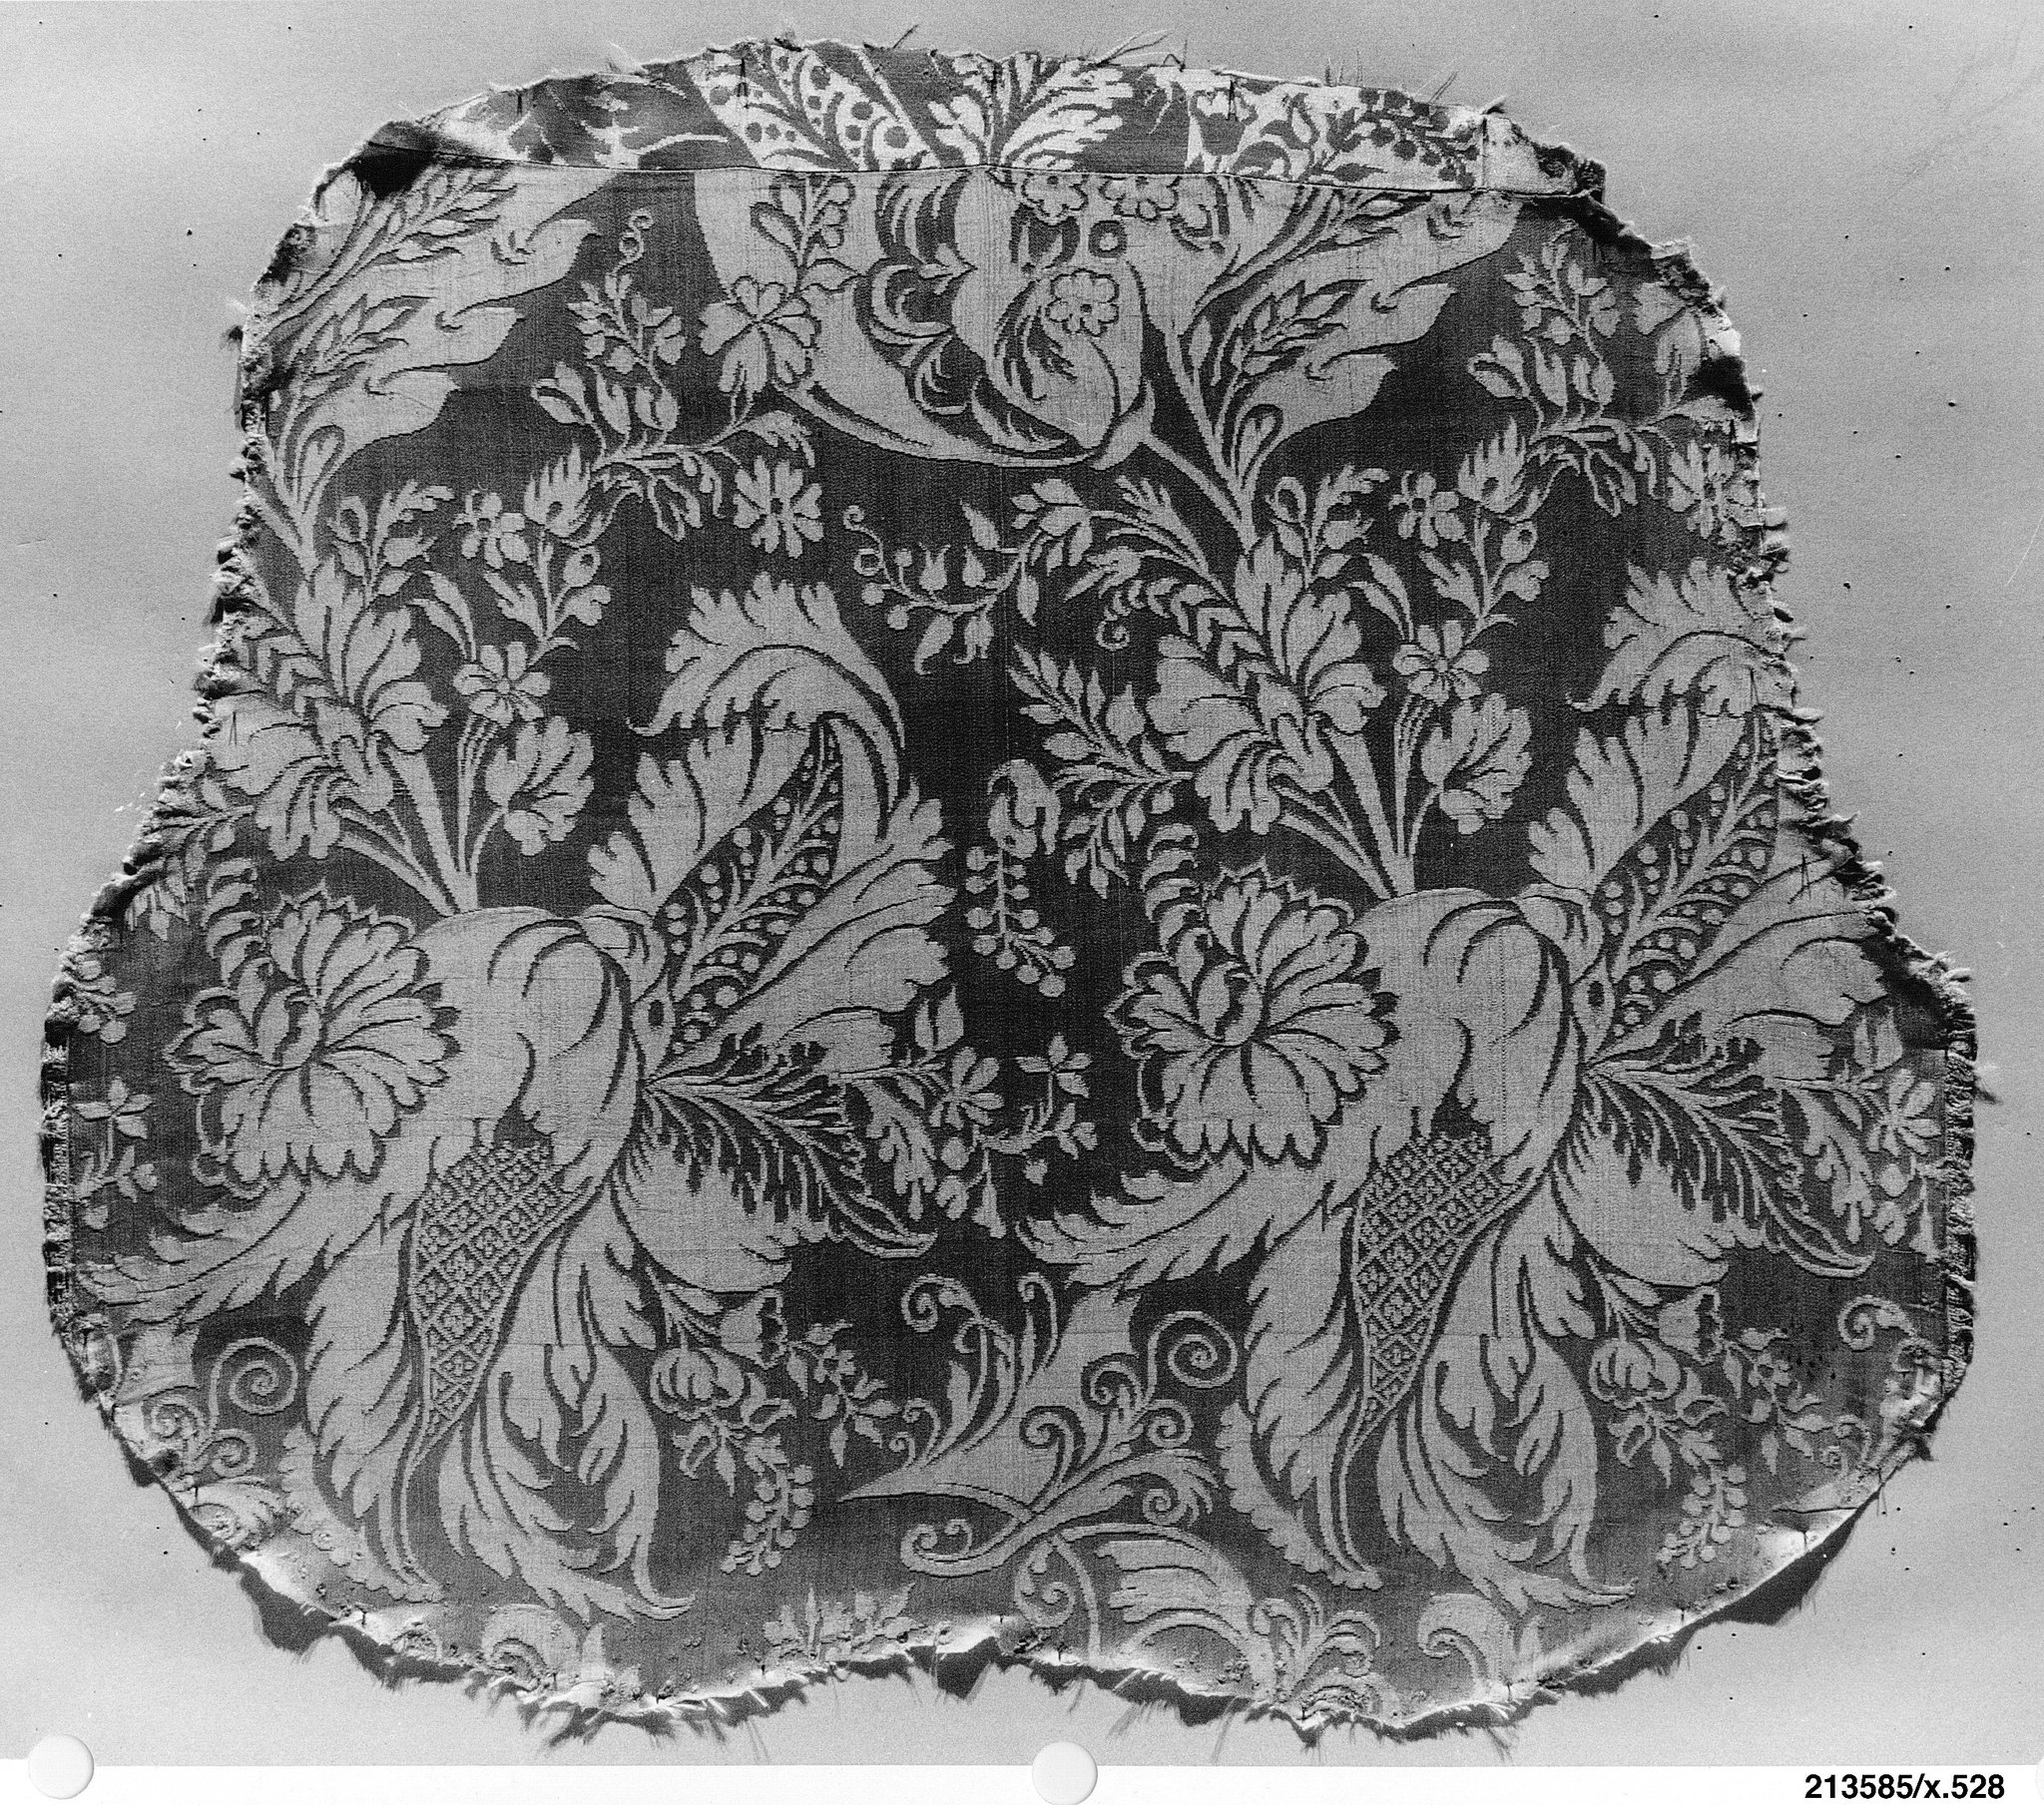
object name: upholstery panel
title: Chair seat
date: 1701-1800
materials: silk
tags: flowers